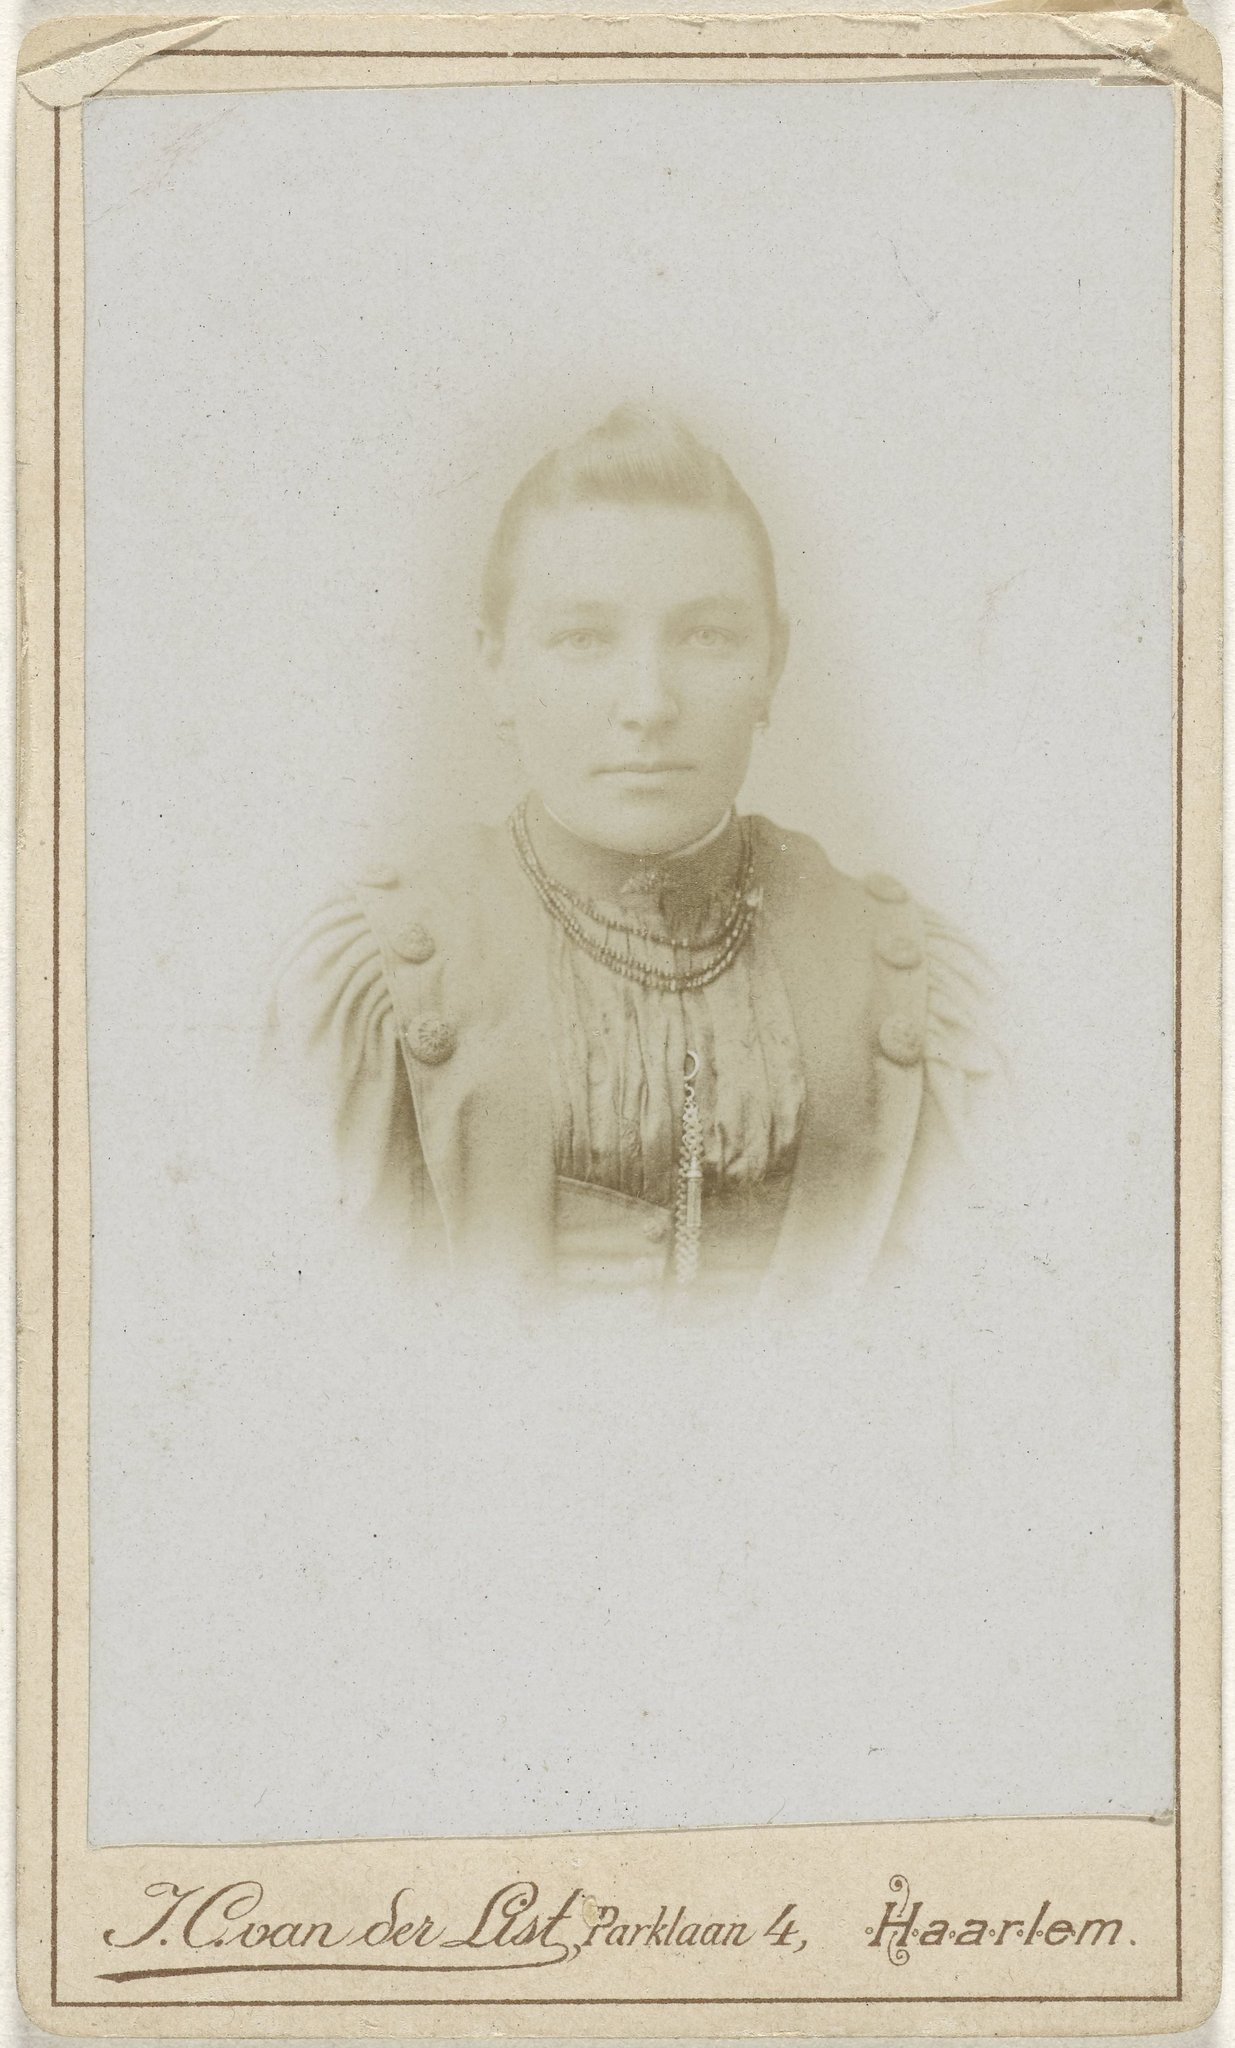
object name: carte de visite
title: Studioportret dame met ketting, buste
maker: j.c. van der list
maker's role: fotograaf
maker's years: 1857-1935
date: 1908-1915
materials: photographic support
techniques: albumen print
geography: haarlem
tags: chest, bust - aa - female human figure, haarlem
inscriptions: name: ‘Photographie instantanee J.C. van der List Parklaan no 4 bij het Kenaupark, Haarlem’